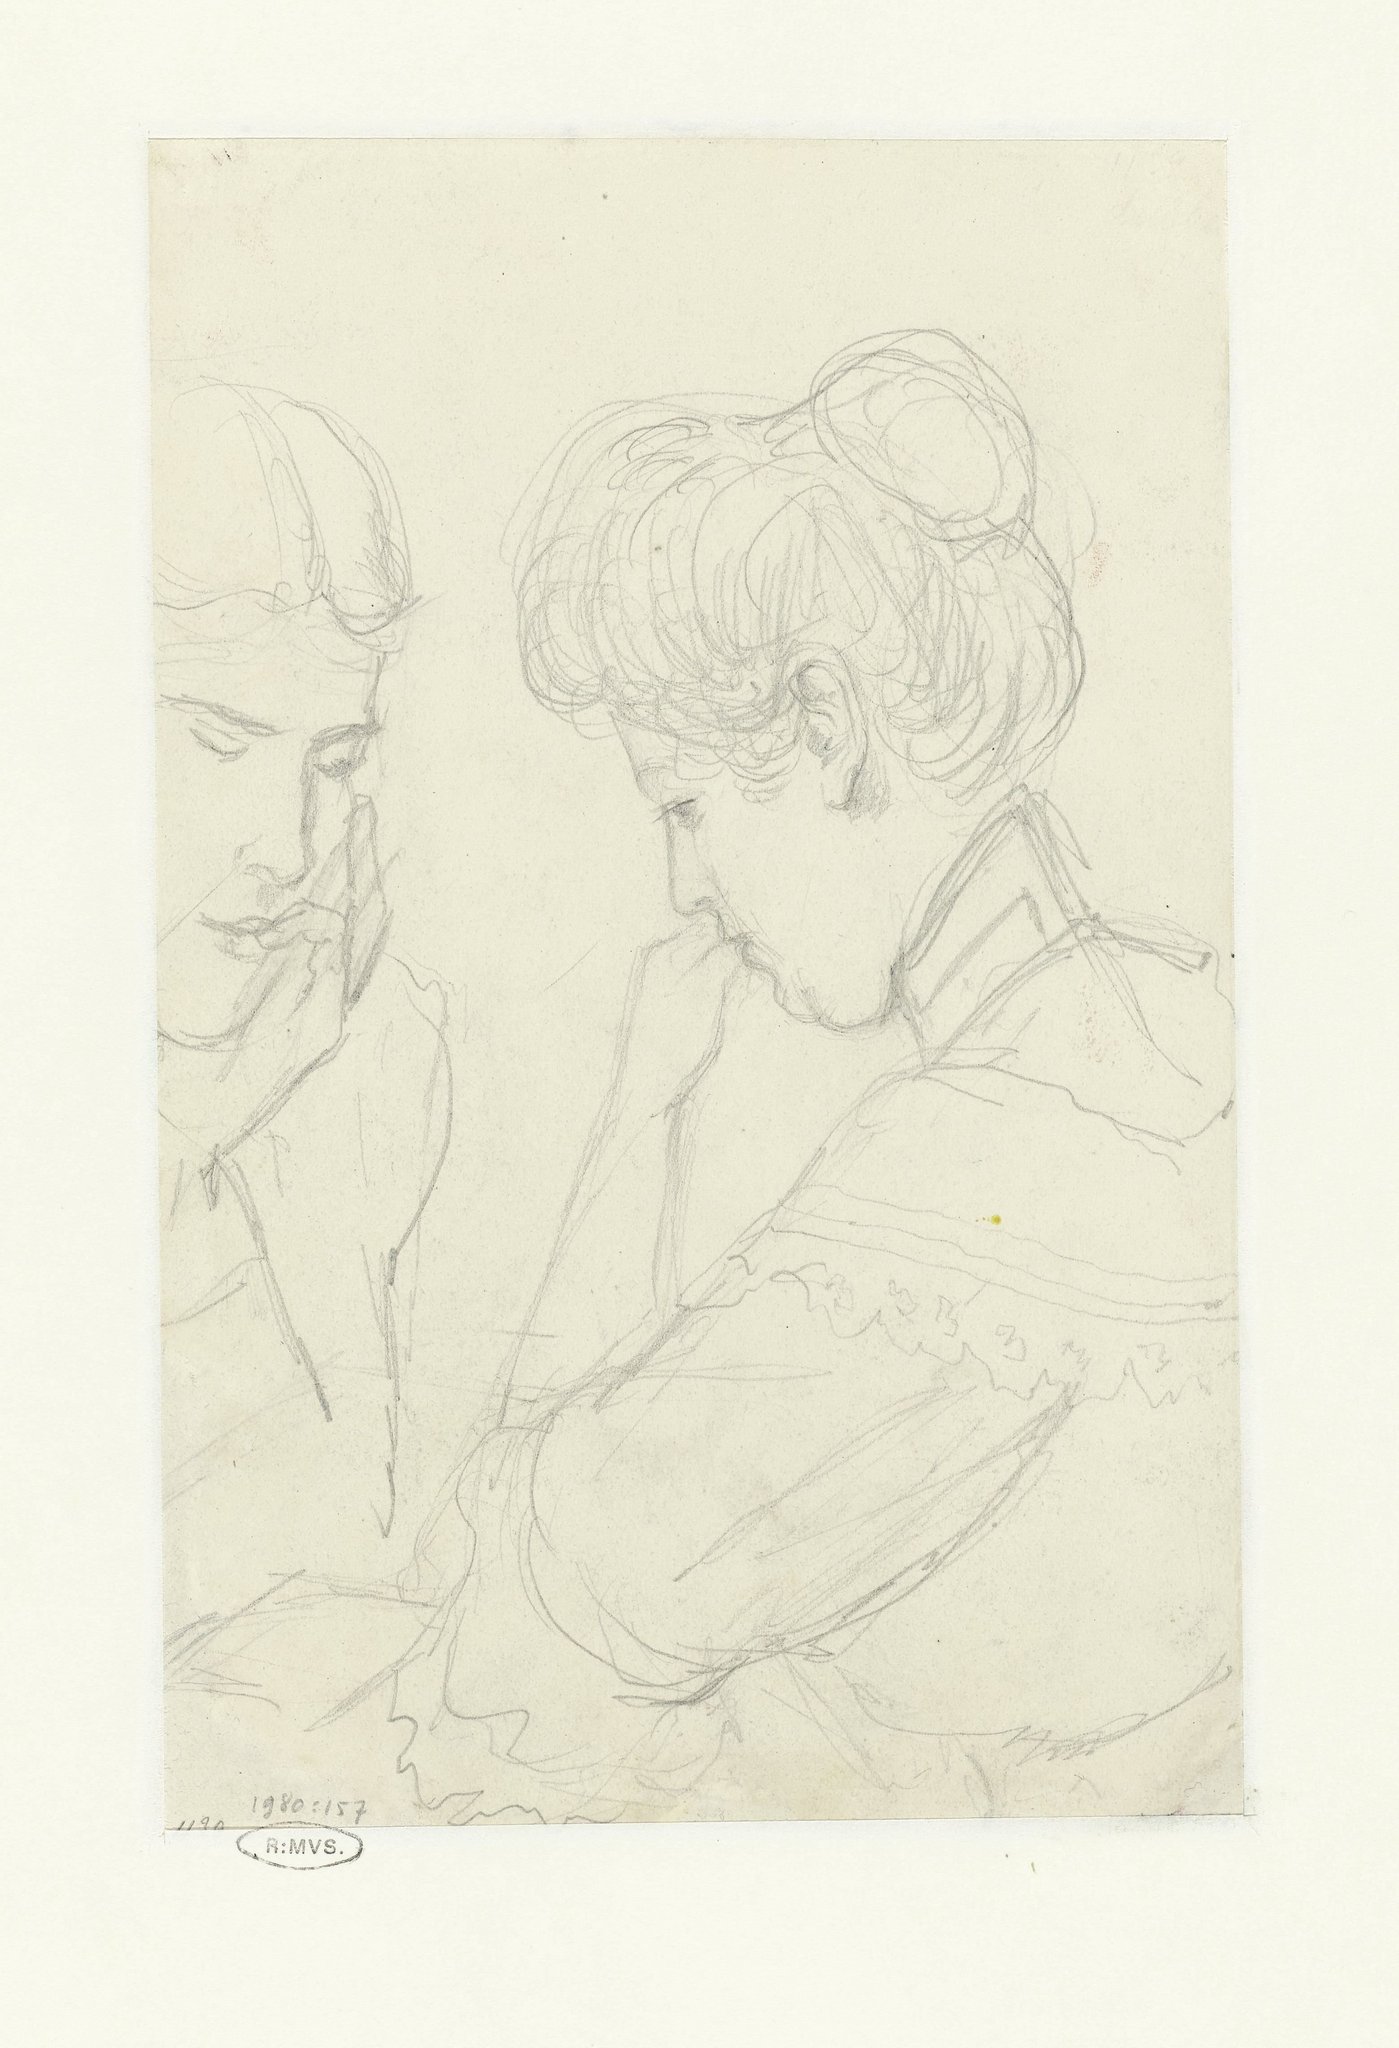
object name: drawing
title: Twee tegenover elkaar zittende vrouwen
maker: jozef israëls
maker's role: draughtsman, painter, print maker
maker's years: 1824-1911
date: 1834-1911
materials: paper, pencil